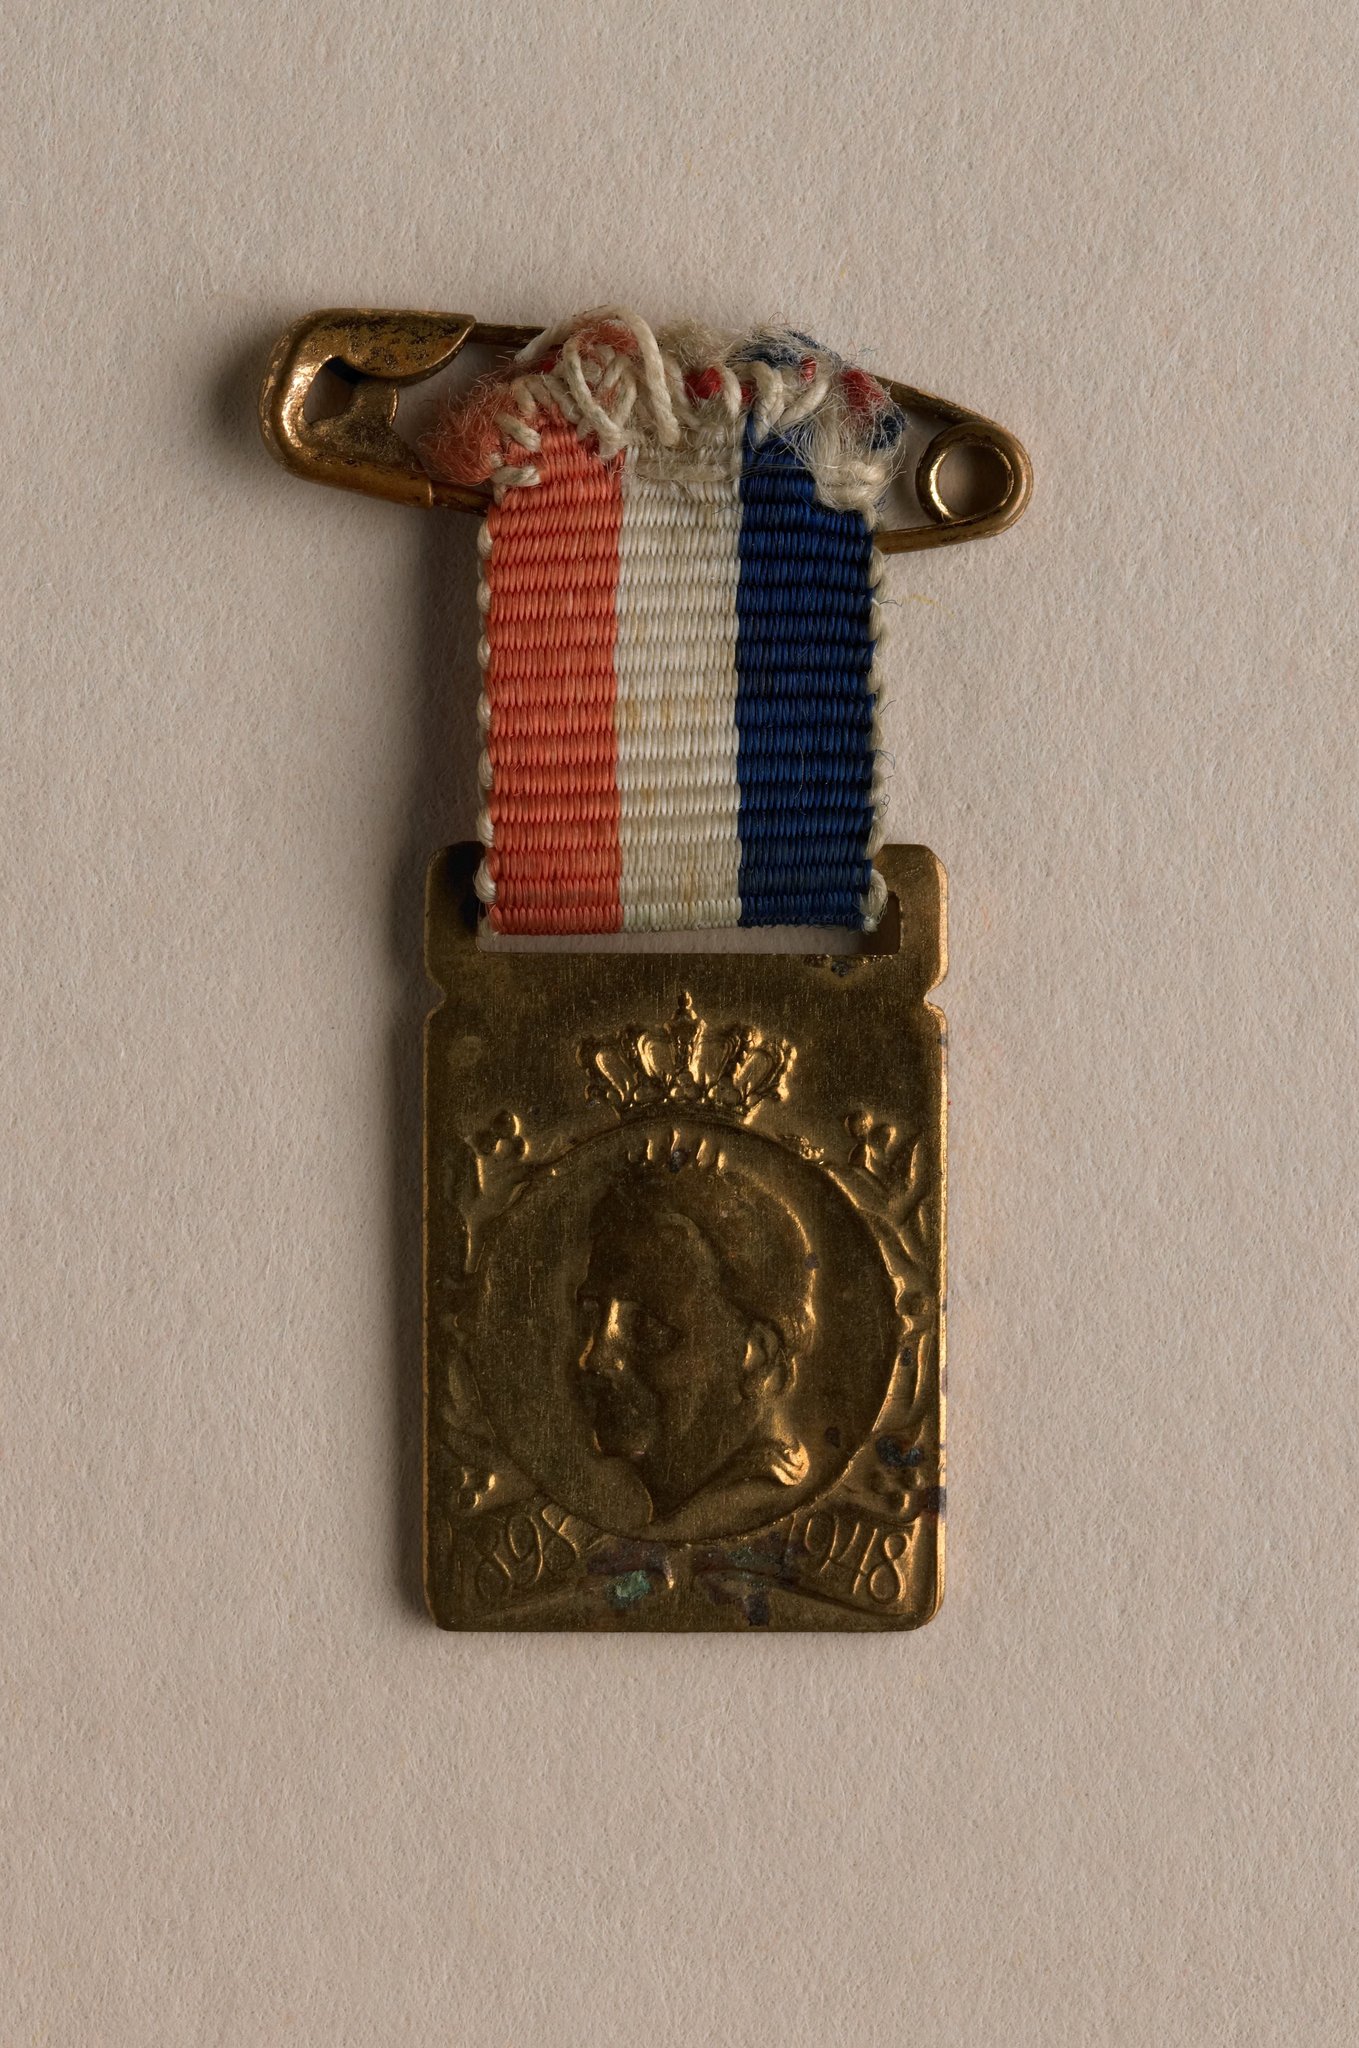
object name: insignia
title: Draagteken met beeltenis koningin Wilhelmina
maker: Anonymous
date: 1948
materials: brass, textile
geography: netherlands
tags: the hague, print maker, wilhelmina of the netherlands, netherlands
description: Draagteken met beeltenis Wilhelmina, vervaardigd naar aanleiding van het 50 jarige regeringsjubileum van Koningin Wilhelmina. In een gekroond medaillon is het portret van Wilhelmina zichtbaar. In de banderol onder het medaillon de jaartallen 1898 en 1948. Aan het messing draagteken is een rood wit blauw lintje met een eenvoudige veiligheidspeld bevestigd.